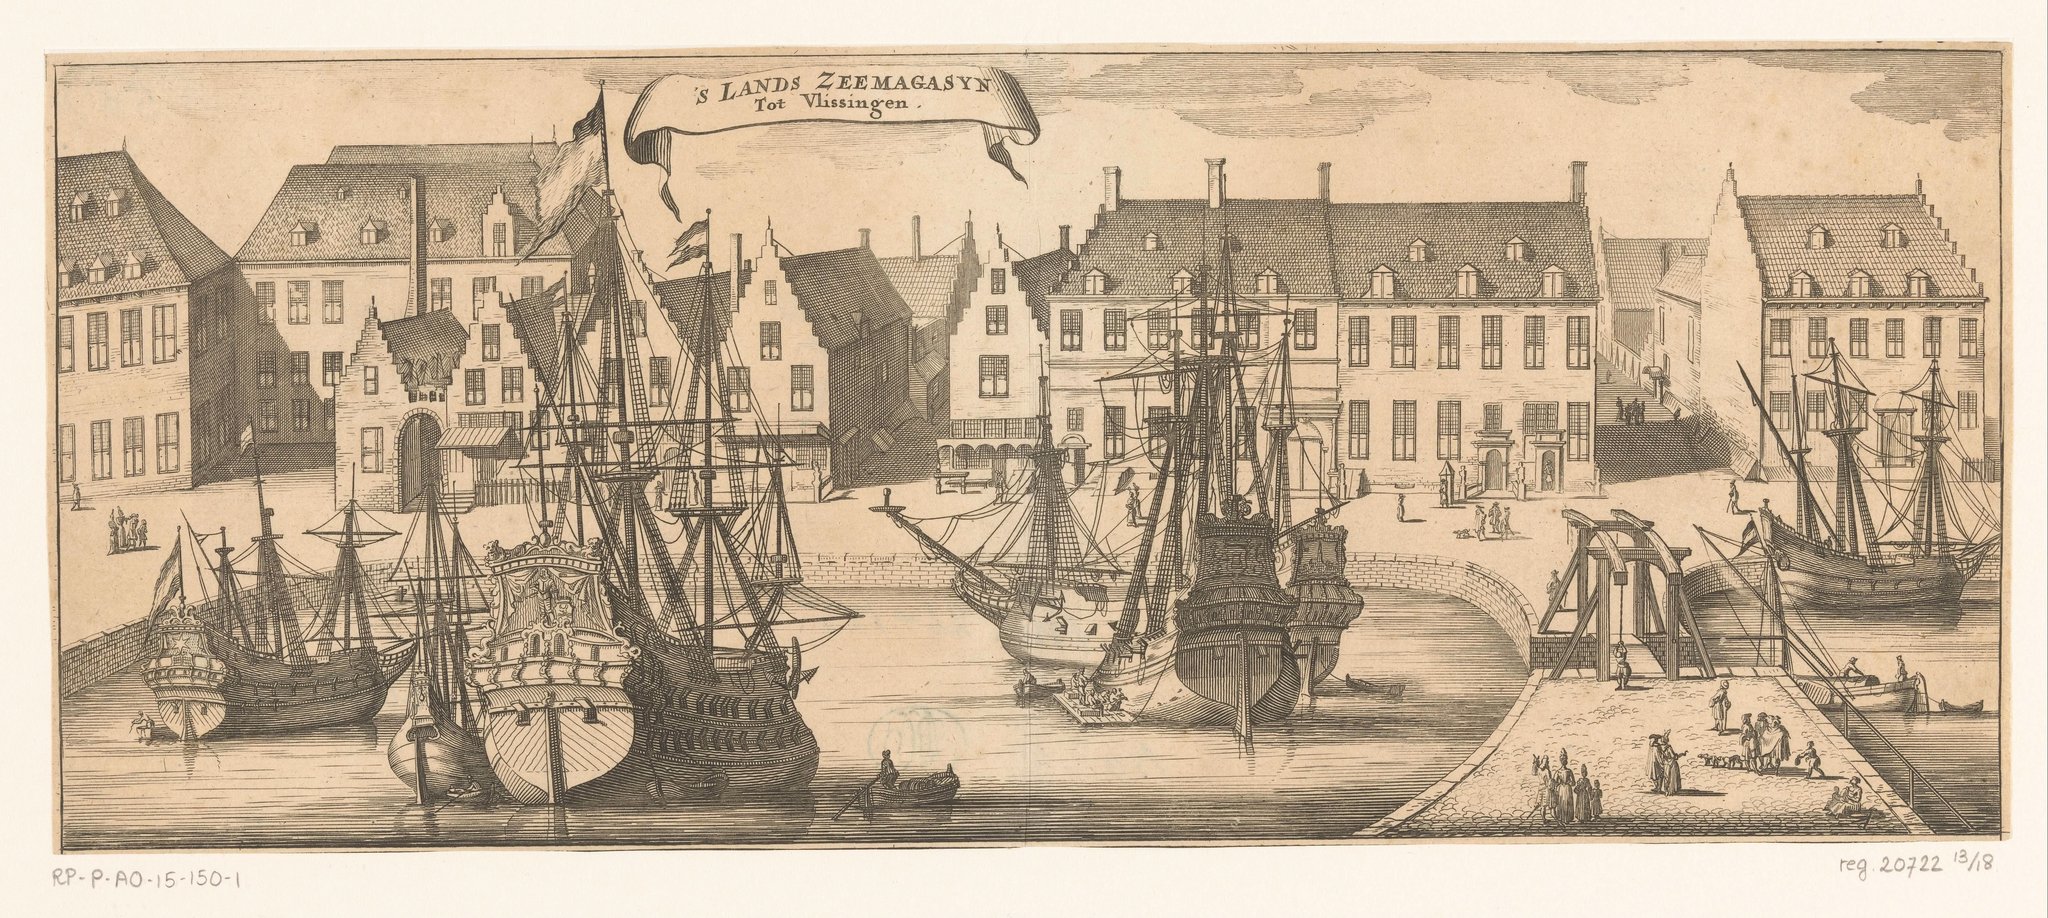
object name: book illustration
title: Gezicht op 's Lands Zeemagazijn te Vlissingen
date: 1696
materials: paper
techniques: engraving, etching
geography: middelburg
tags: large-scale structure for storage, e.g.: warehouse, depot, silo, ammunition store, arsenal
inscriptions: collector's mark: Lugt 195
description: Oorspronkelijk van één plaat gedrukt met twee andere voorstellingen (zie RP-P-AO-15-150-2 en RP-P-AO-15-150-3). Huidige staat van prent in zijn geheel ook gebruikt in: Smallegange, Mattheus. Nieuwe Cronyk van Zeeland (…). Middelburg en Amsterdam: Johannes Meertens en Abraham van Someren, 1696. Latere staat van prent (zonder nummering rechtsboven en plaat versneden tot twee of drie platen) ook gebruikt in: Aa, Pieter van der. La galerie agreable du monde (...). 66 delen. Leiden: Pieter van der Aa, 1728, dl. 21.